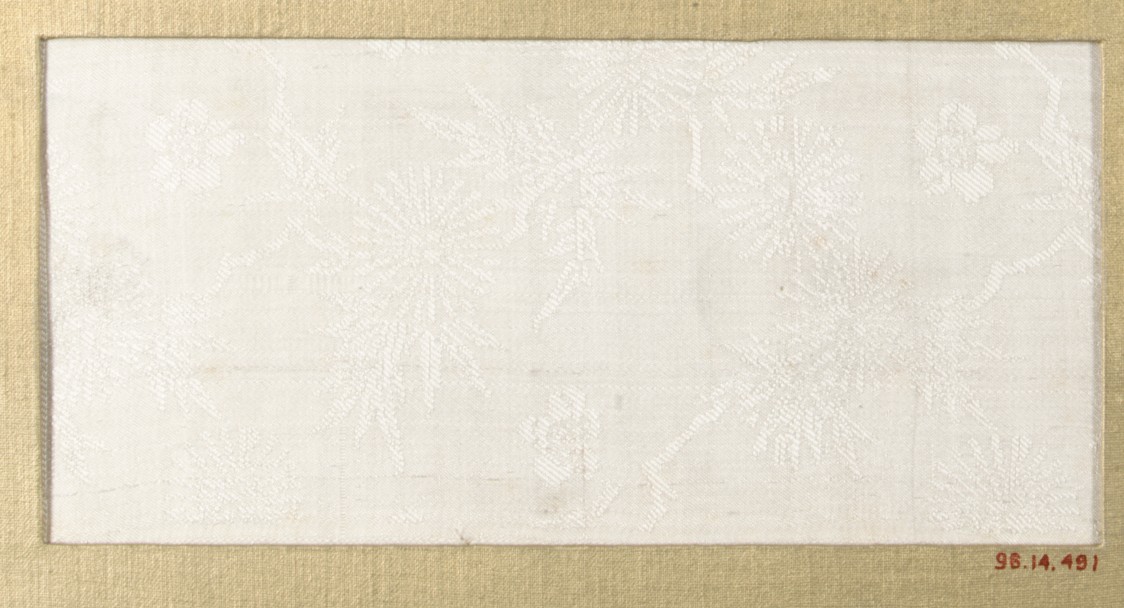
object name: piece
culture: japanese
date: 1701-1900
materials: silk